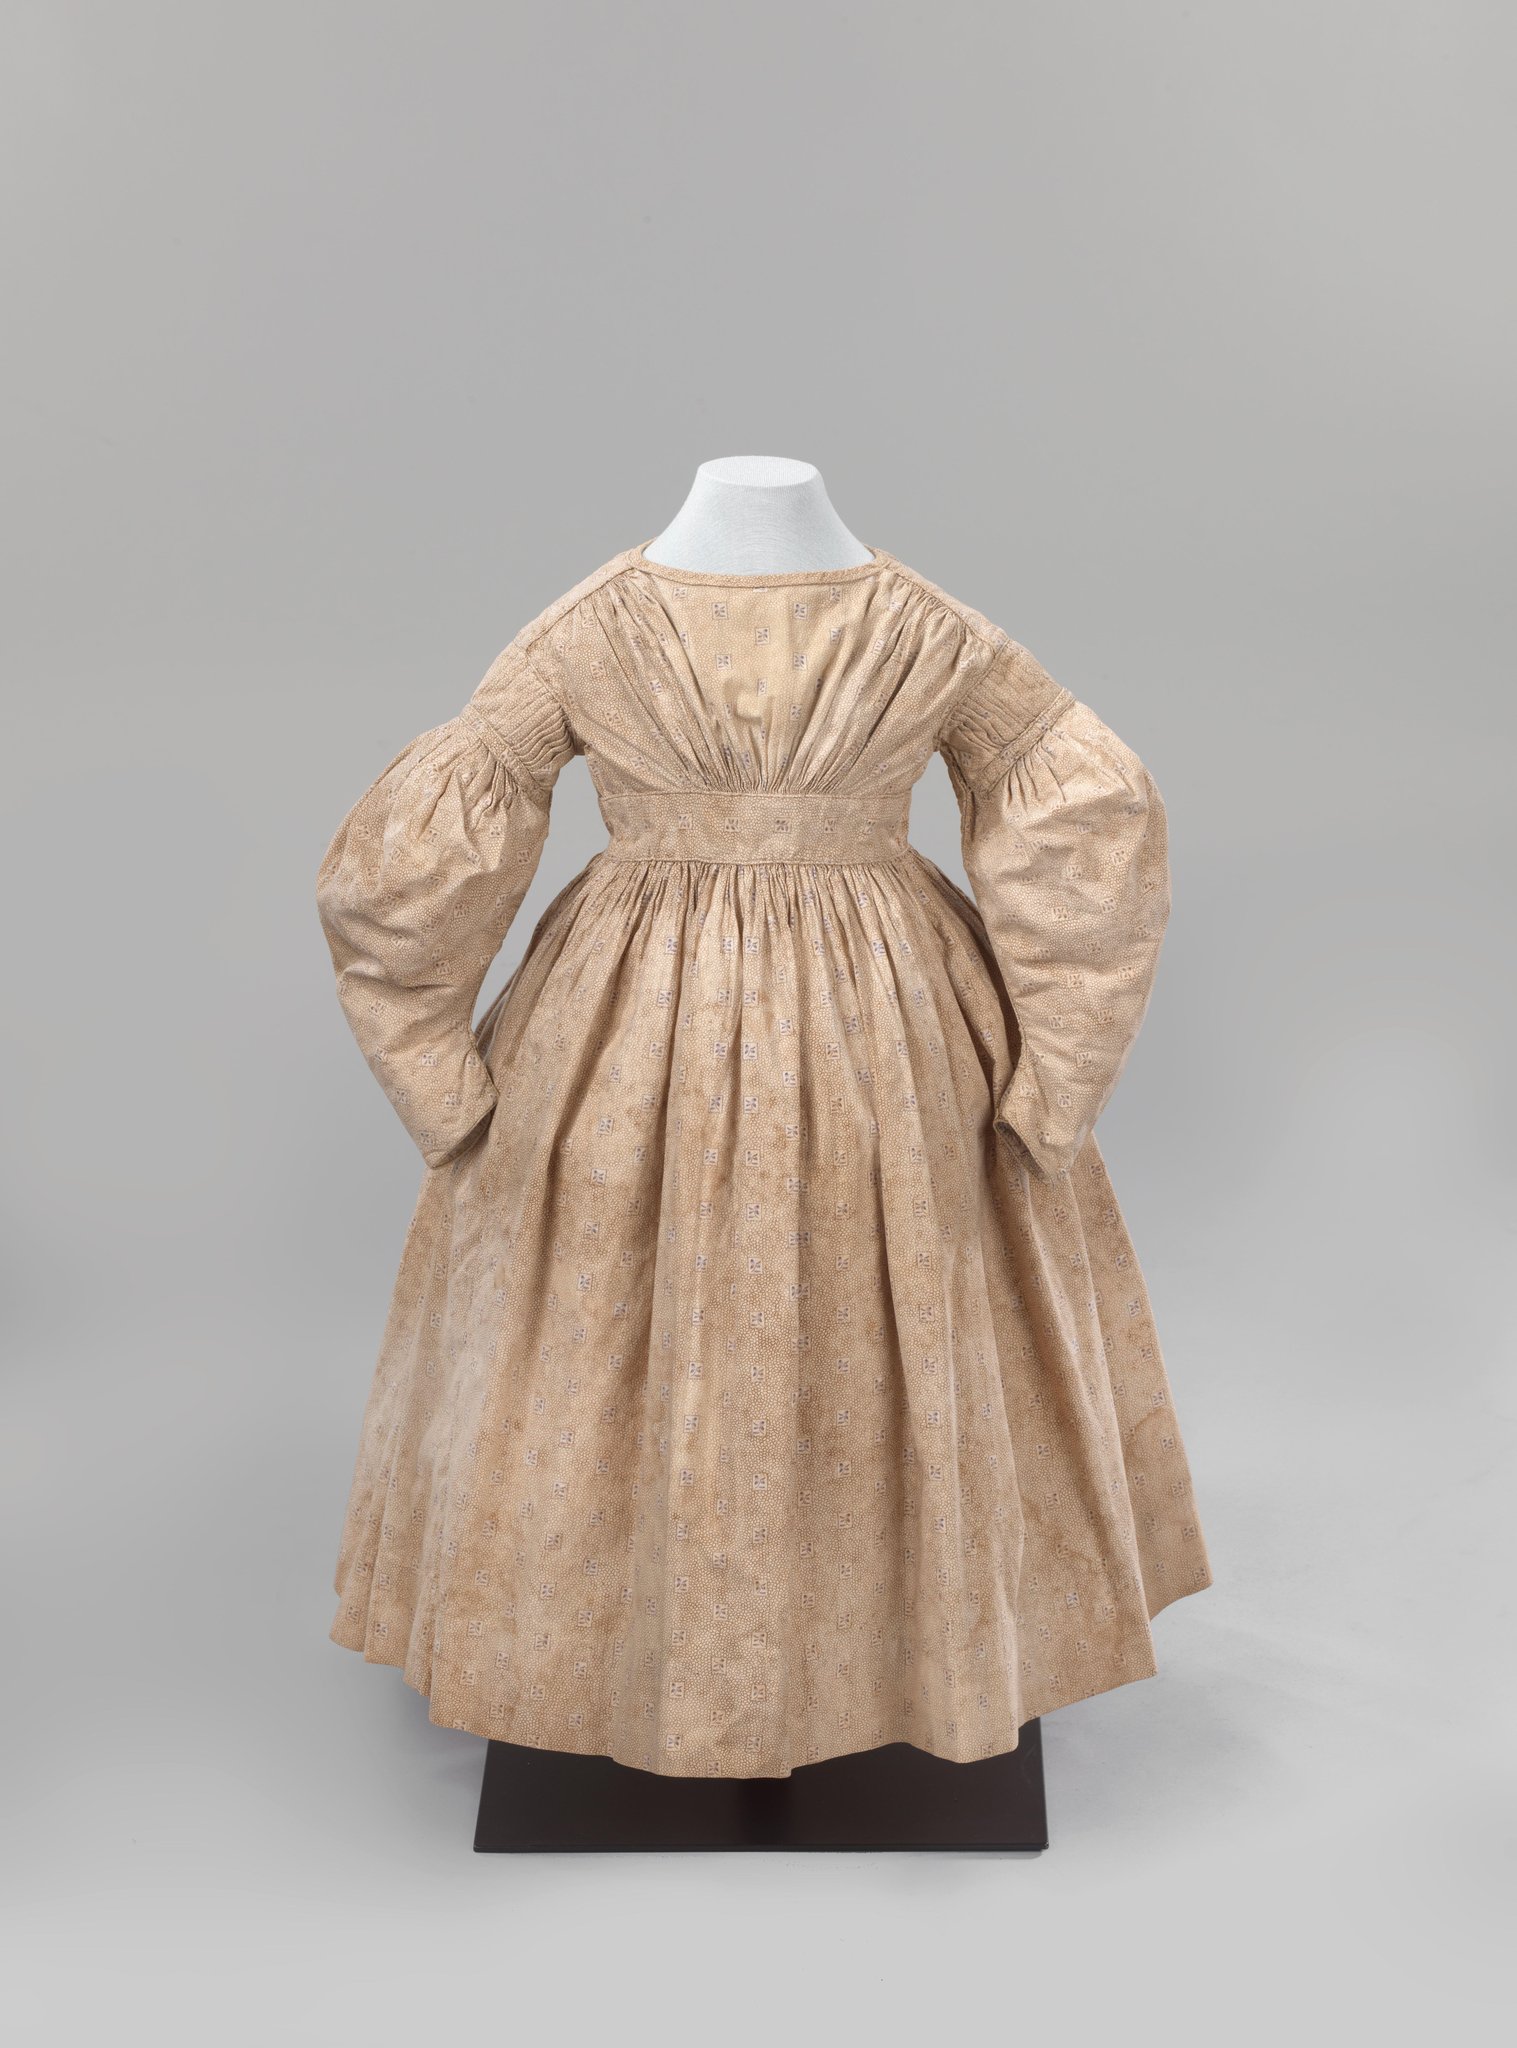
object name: robe, japon, jurk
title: Japon van katoen, bedrukt met bruin rasterpatroon en strooimotief van bloempje in vierkant, met boothals, lange mouwen, gerimpeld lijf en rok. Lijf gevoerd met linnen.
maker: Anonymous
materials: cotton, linen, metal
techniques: casting, printing, weave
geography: netherlands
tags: trijntje van leyden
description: Japon van katoen, bedrukt met bruin rasterpatroon en strooimotief van bloempje in vierkant, met ronde hals, lange mouwen, gerimpeld lijf en rok. Model: kort lijf, aan de voor- en achterkant in het midden voorzien van verticale rimpels. Gerimpeld aan de schouderpas. Brede, gladde tailleband. Wijde rok, gerimpeld aan tailleband gezet. Lange wijde mouwen met geplooide rand boven op de schouder. Sluiting middenachter door middel van twee metalen haken aan gefestoneerde oogjes. Tunnel rond de hals met dunne linnen veter. Lijf gevoerd met linnen.